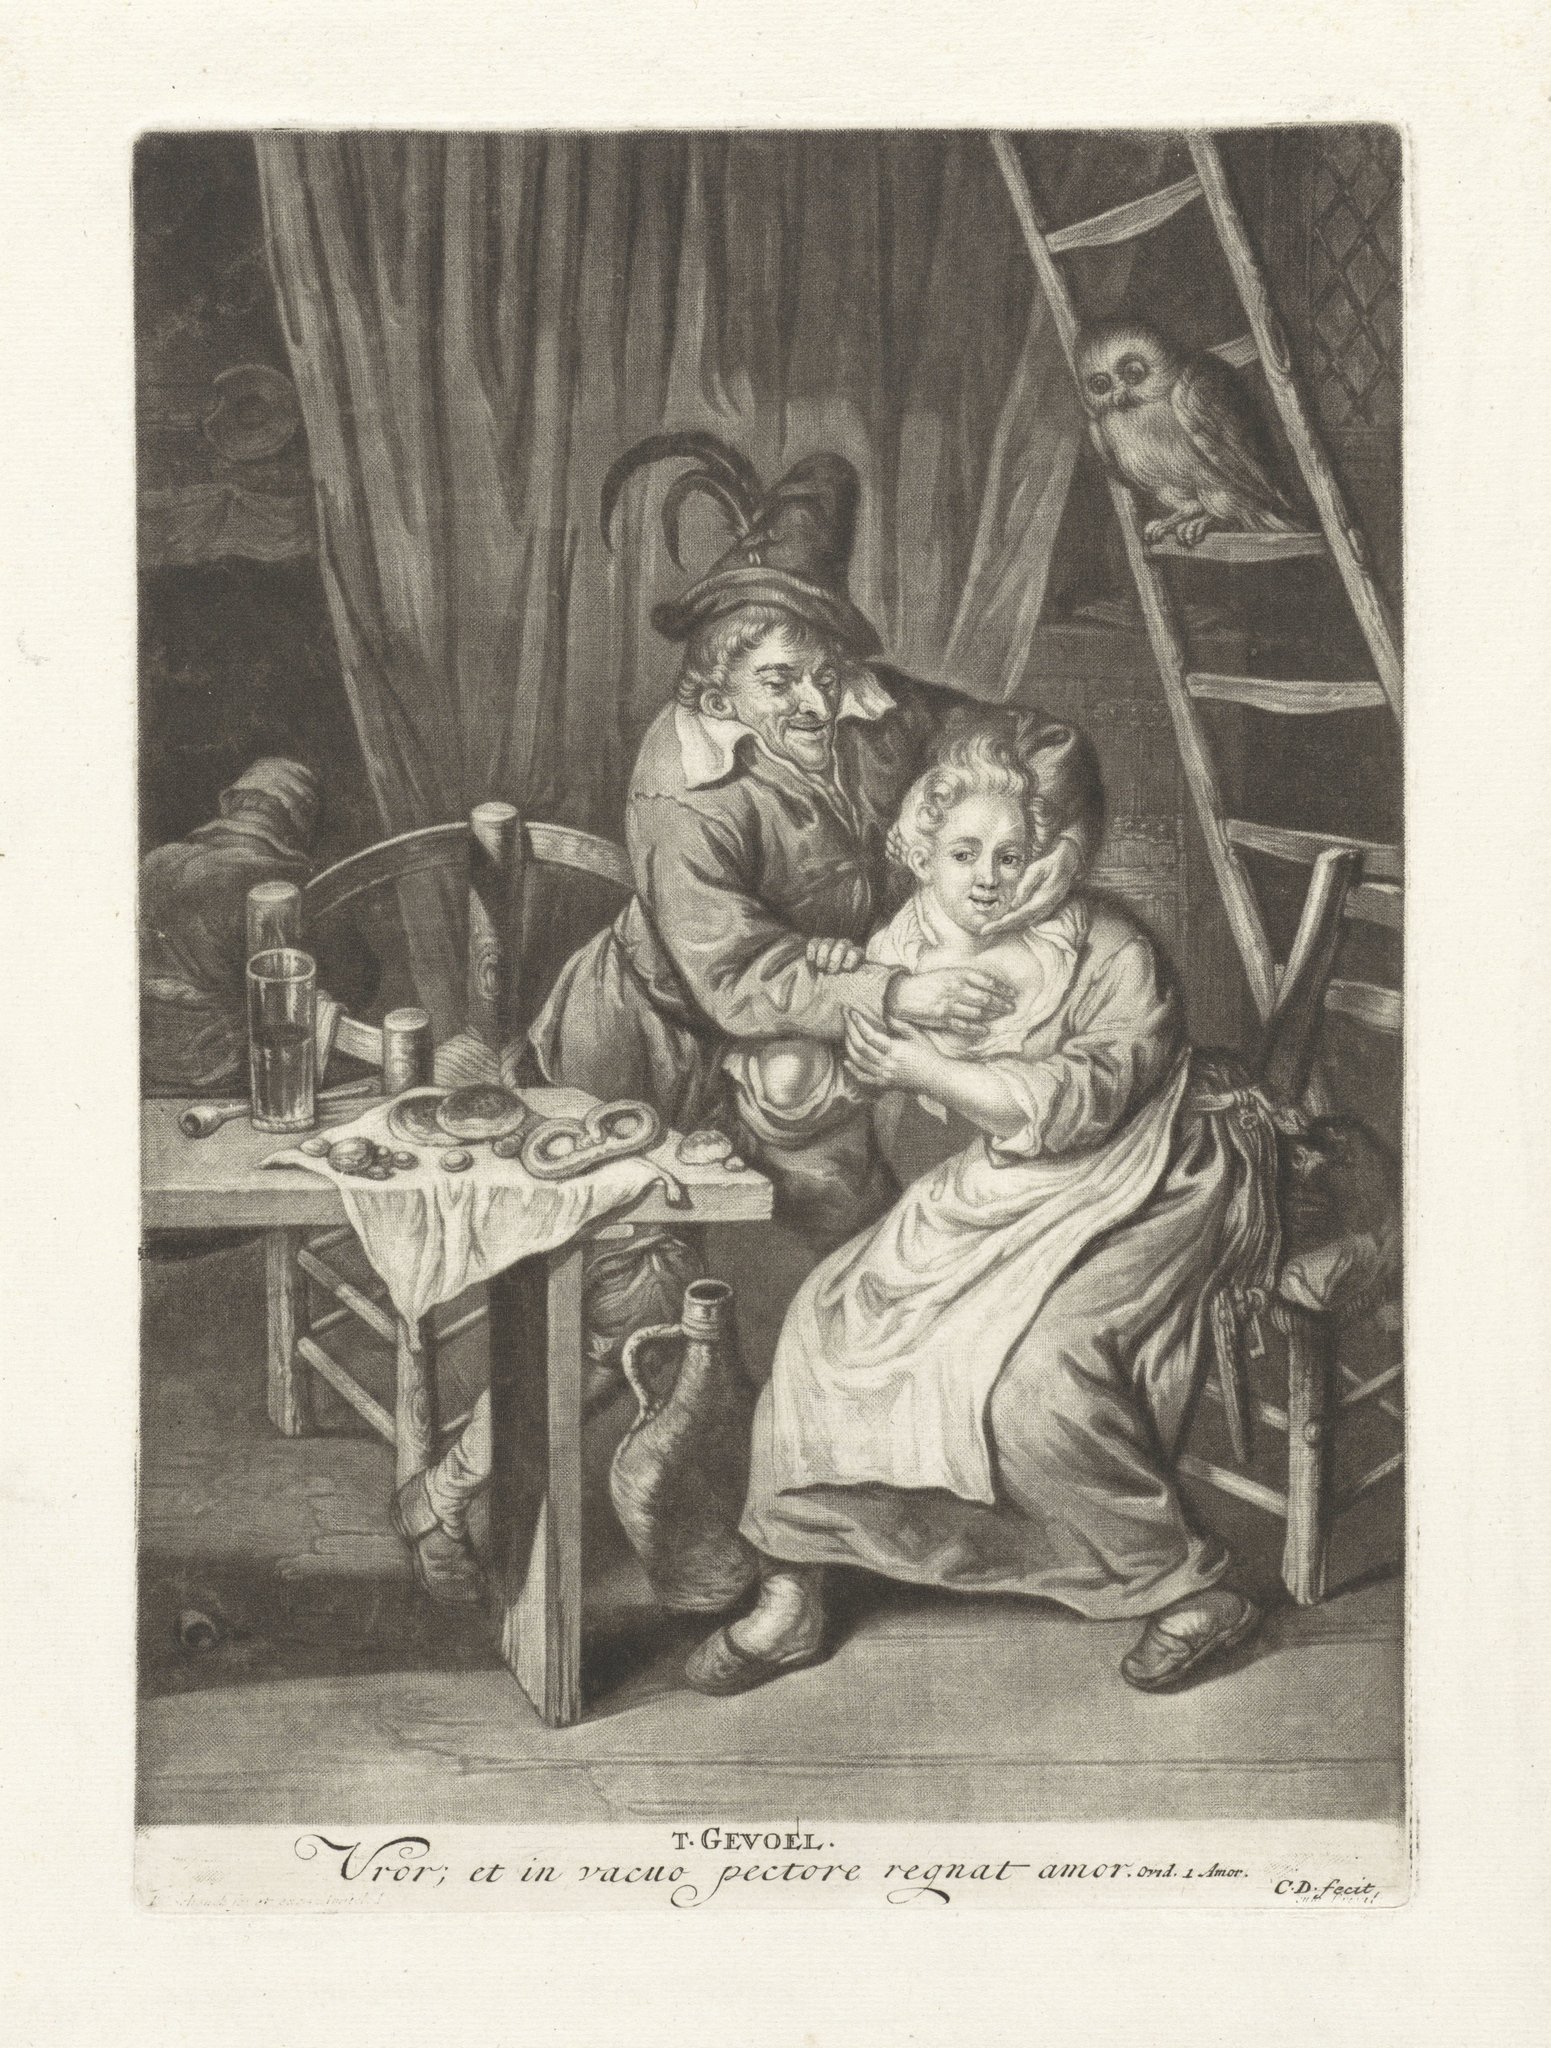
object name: print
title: De vijf zintuigen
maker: cornelis dusart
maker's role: draughtsman, painter, print maker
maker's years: 1660-1704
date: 1670-1704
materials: paper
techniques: engraving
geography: haarlem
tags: feeling (one of the five senses), owls, (feeling of) attraction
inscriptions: collector's mark: Lugt 2228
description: In een vertrek betast een man een jonge vrouw. Op de ladder achter hen zit een uil. De prent maakt deel uit van een serie van vijf prenten met de vijf zintuigen.